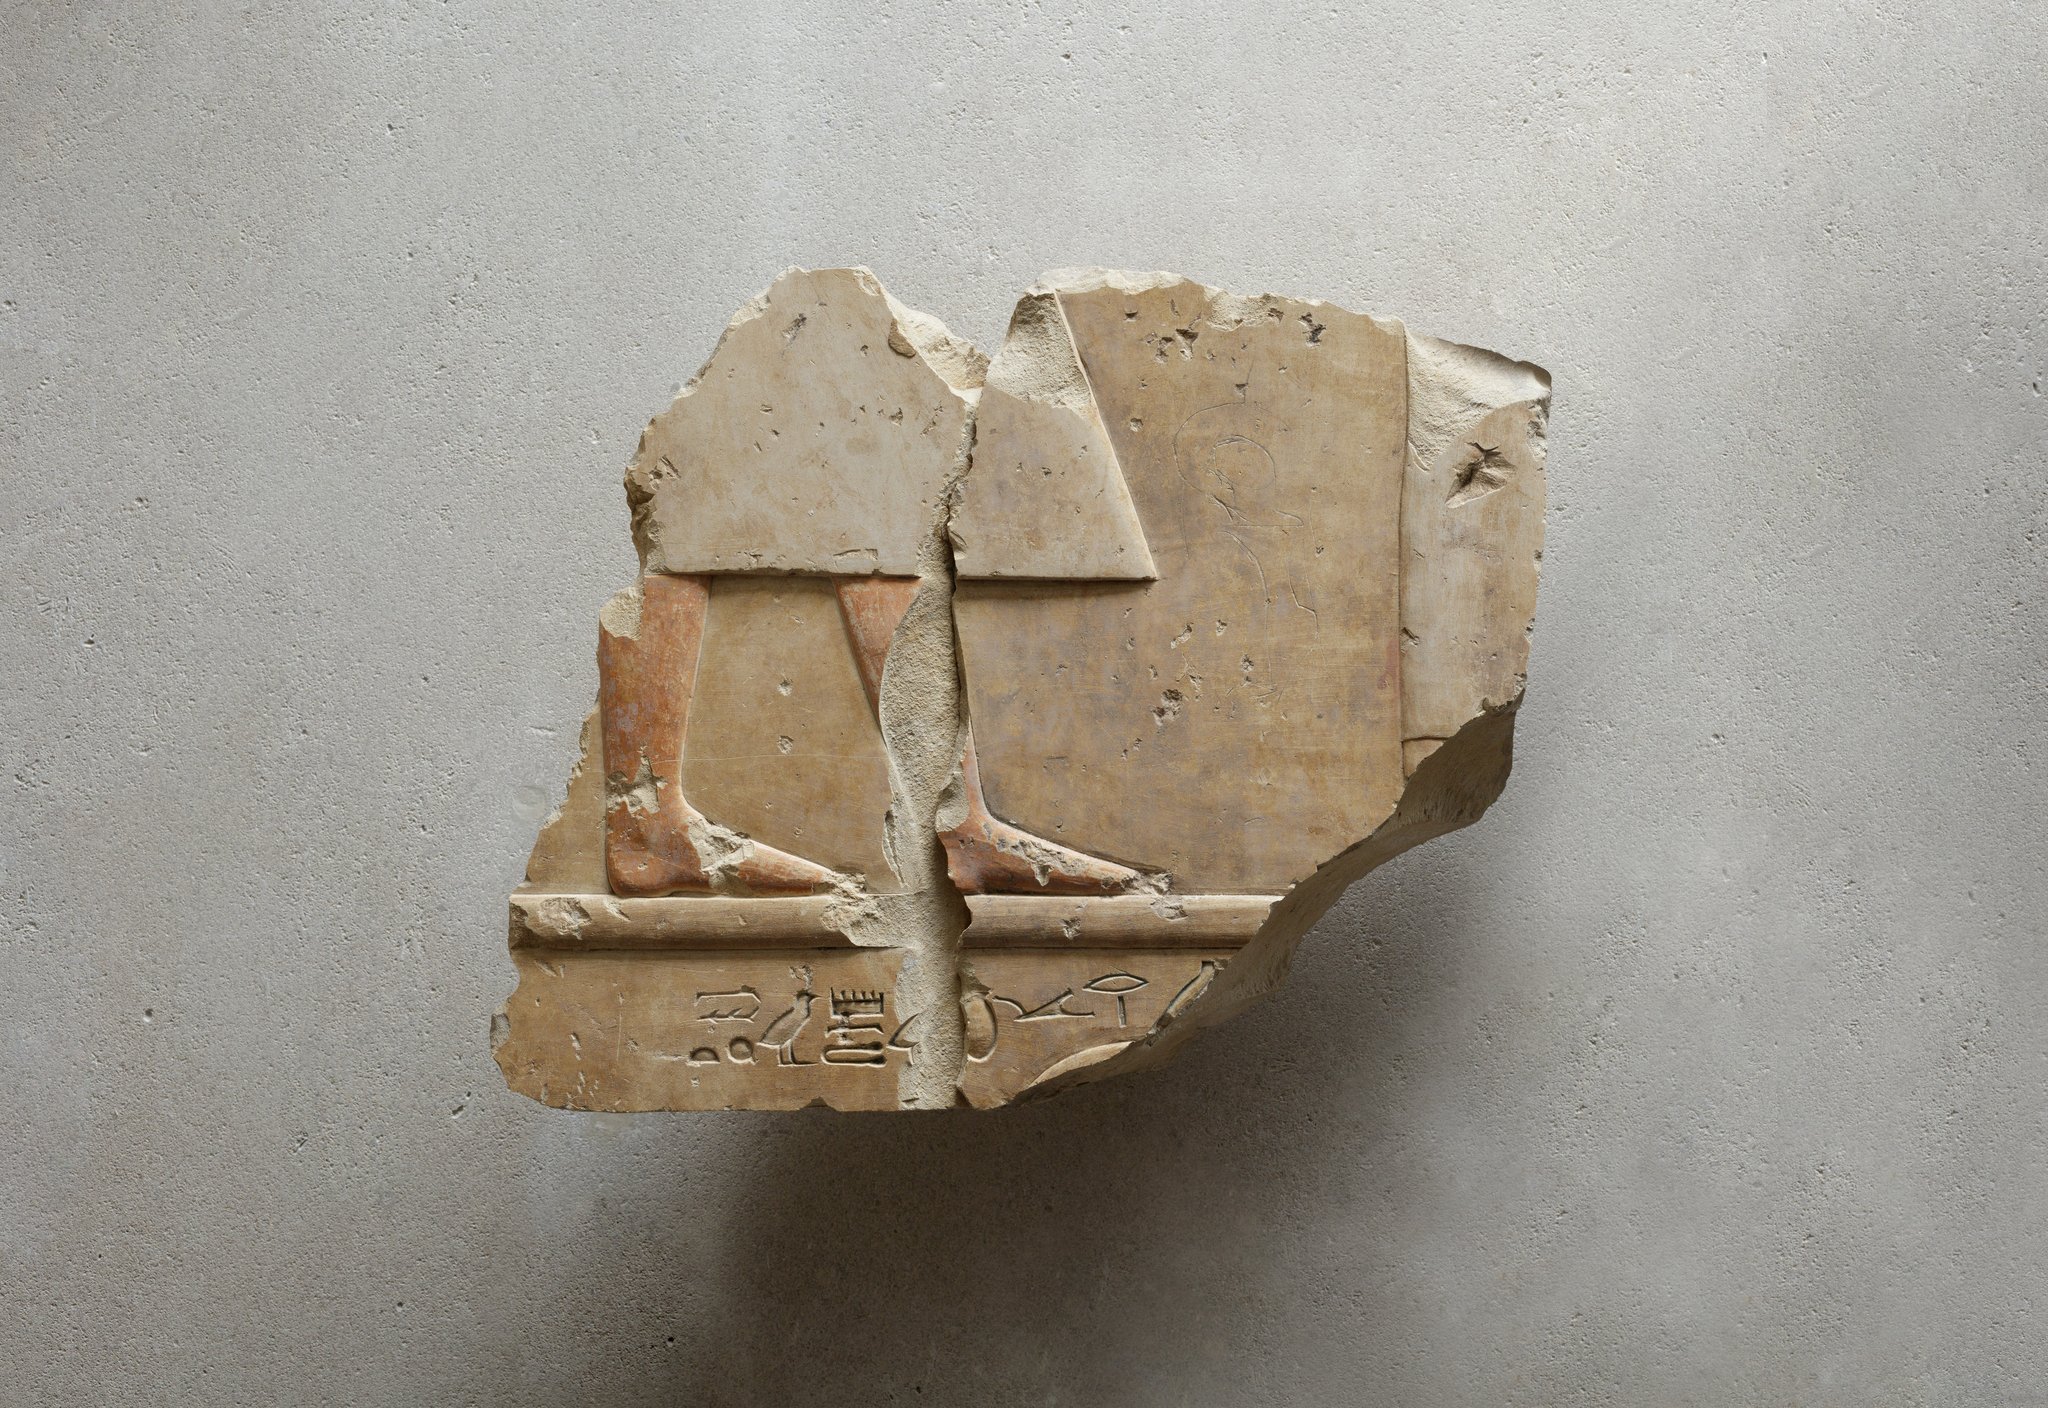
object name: relief, part of male attendant, neferu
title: Relief from the tomb of Queen Neferu: parts of one female and one male attendant (see 26.3.353-1)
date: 2051-2030 BCE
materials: limestone, paint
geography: egypt